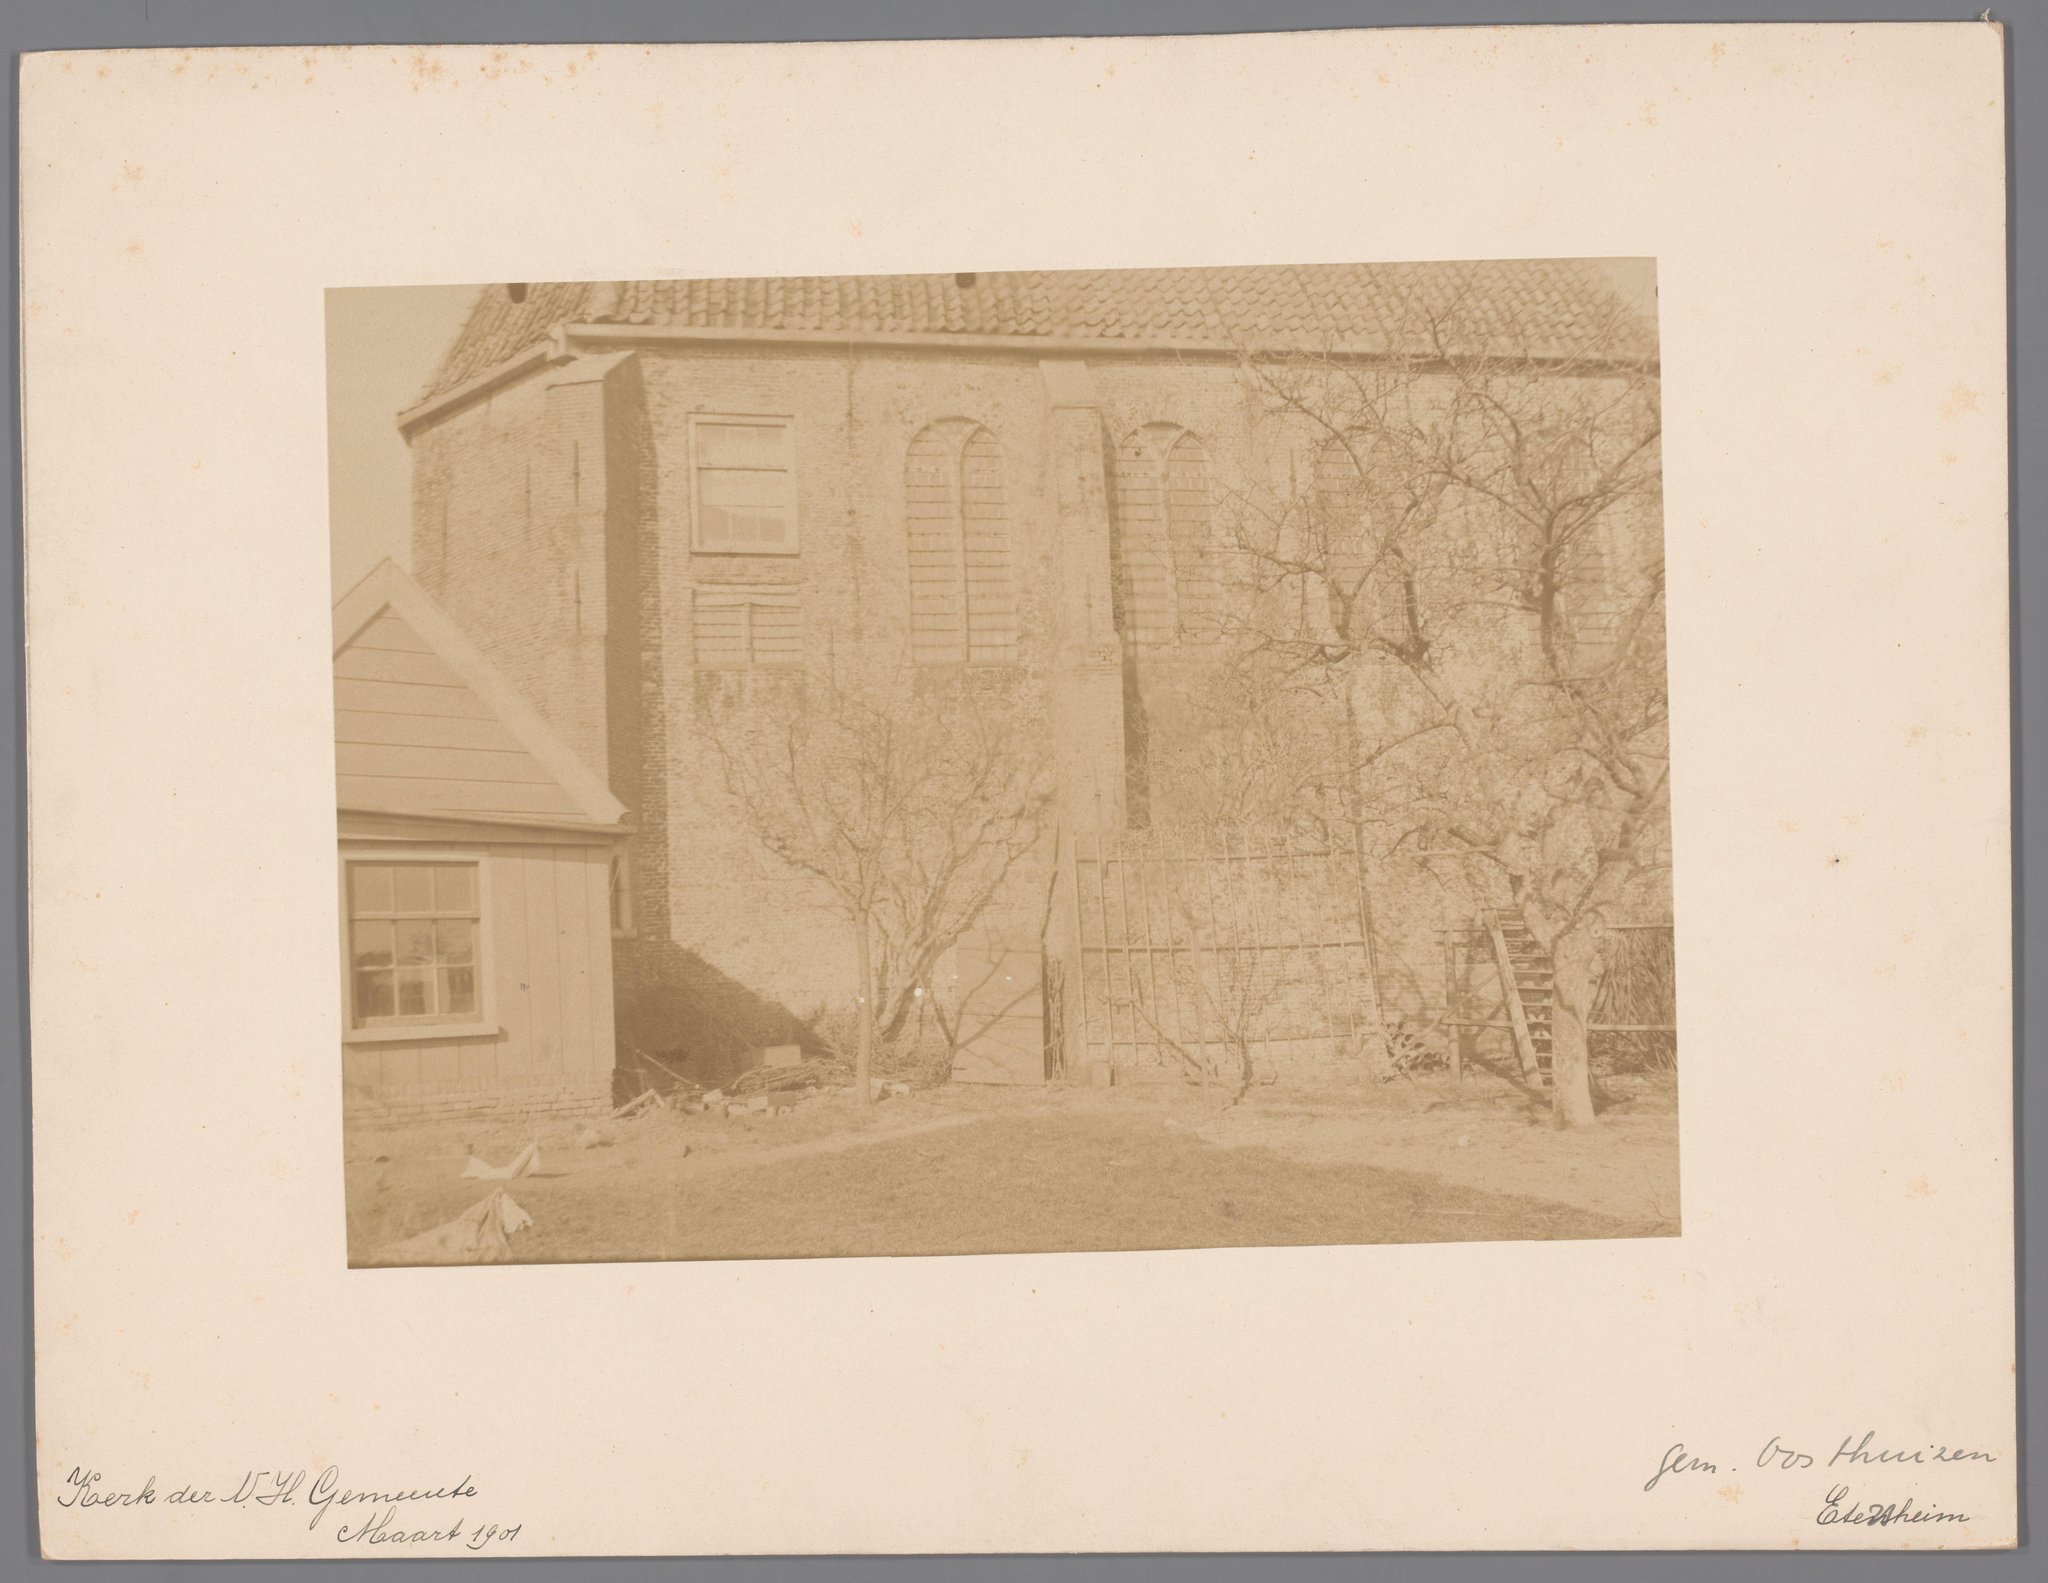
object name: photograph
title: Detail van de Oude Kerk te Etersheim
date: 1901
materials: cardboard, photographic support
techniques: albumen print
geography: etersheim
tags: church (exterior)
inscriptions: annotation: ‘Kerk der Ned Herv gemeente te Etersheim N.H. Maart 1901’, annotation: ‘Kerk der N.H. Gemeente Maart 1901/ gem. Oosthuizen/ Etersheim’